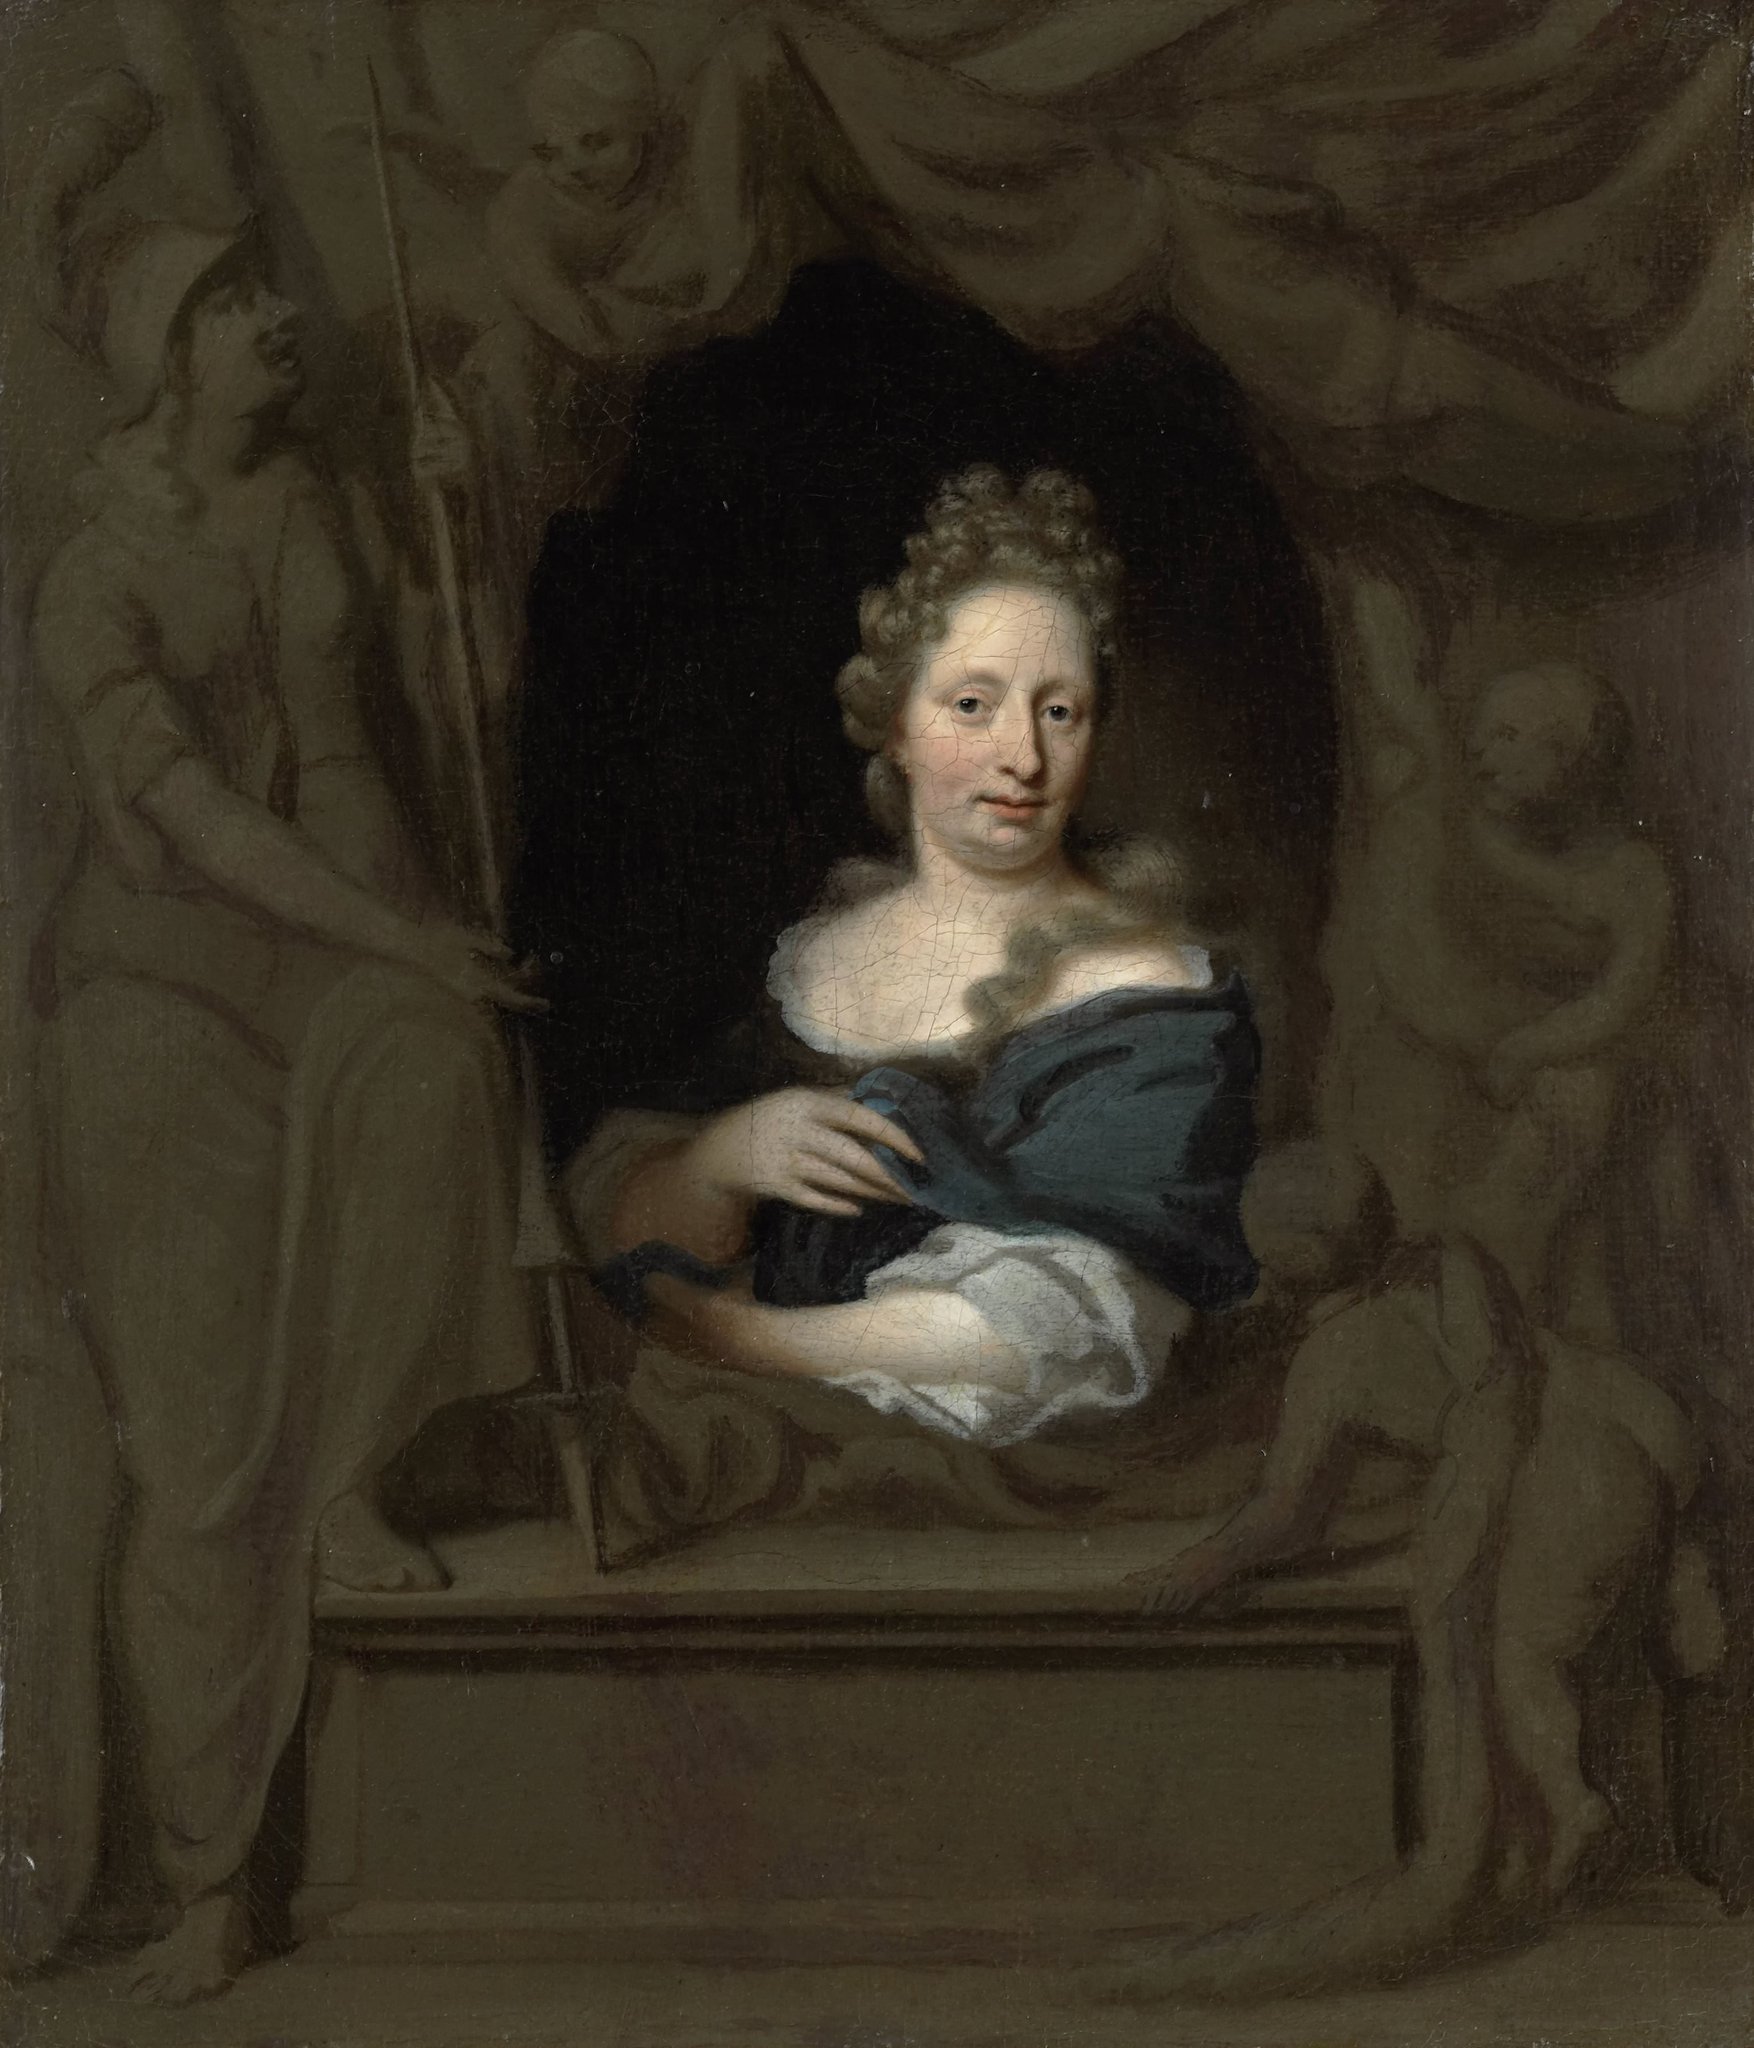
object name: painting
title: Portrait of Eva Visscher, Wife of Michiel van Musscher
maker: michiel van musscher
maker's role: draughtsman, painter, print maker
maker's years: 1645-1705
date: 1685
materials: canvas, oil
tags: eva visscher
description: Portret van Eva Visscher, de echtgenote van de schilder Michiel van Musscher. Zittend, ten halven lijve, in een venster gevormd door draperieïn en een basement. Links Minerva met lans, rechts twee putti. Pendant van SK-A-4232.